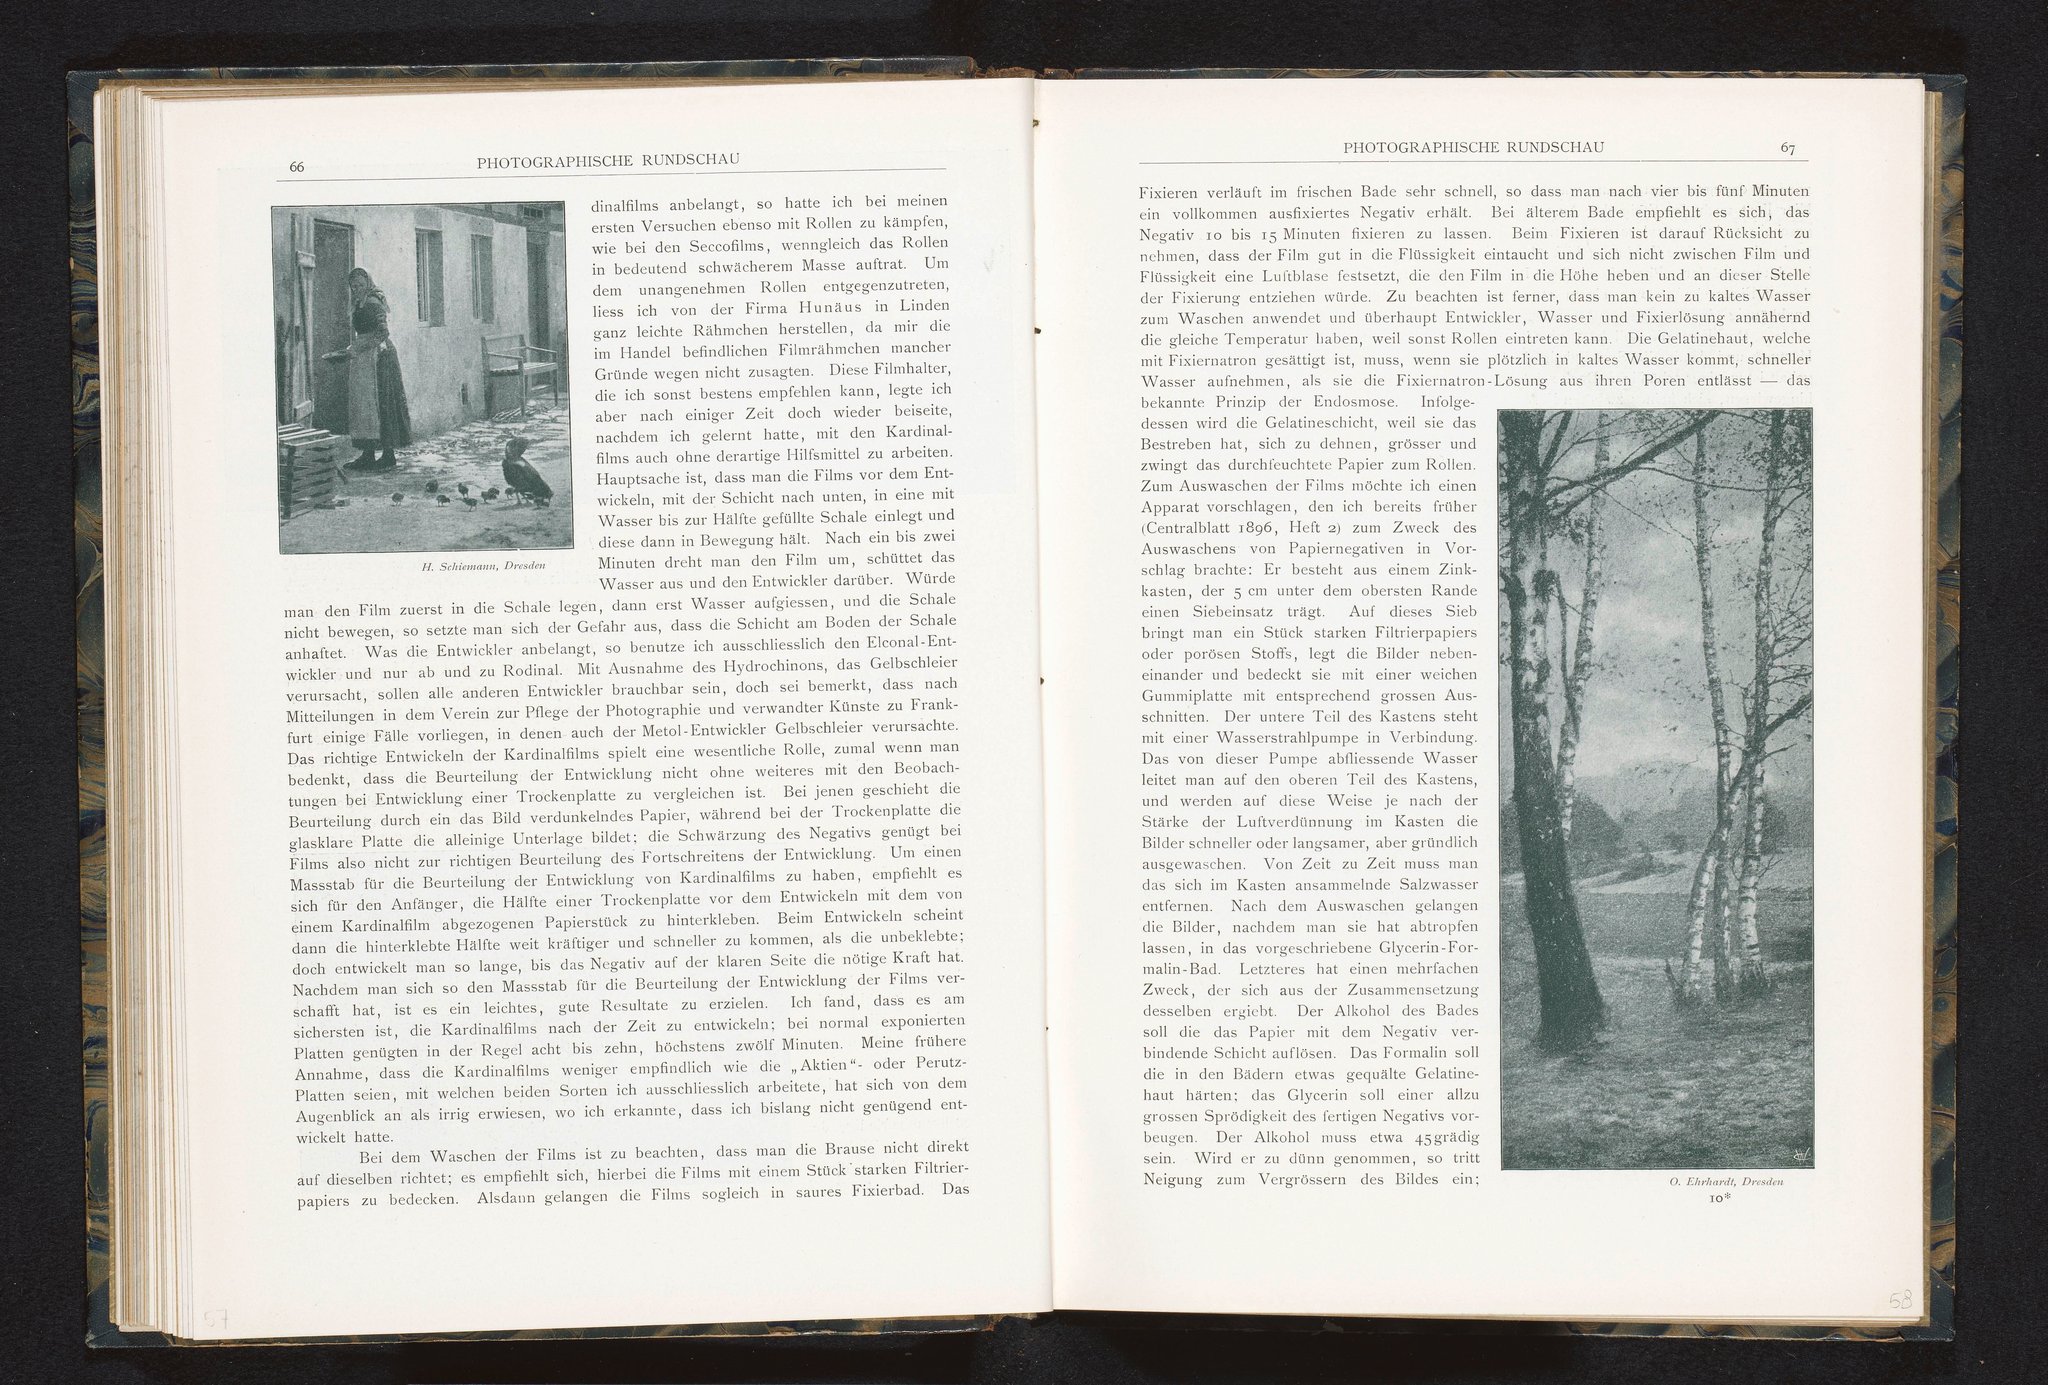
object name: page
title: Gezicht op twee bomen in een landschap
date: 1895-1900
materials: paper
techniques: autotype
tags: trees, landscapes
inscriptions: monogram: ‘WC’